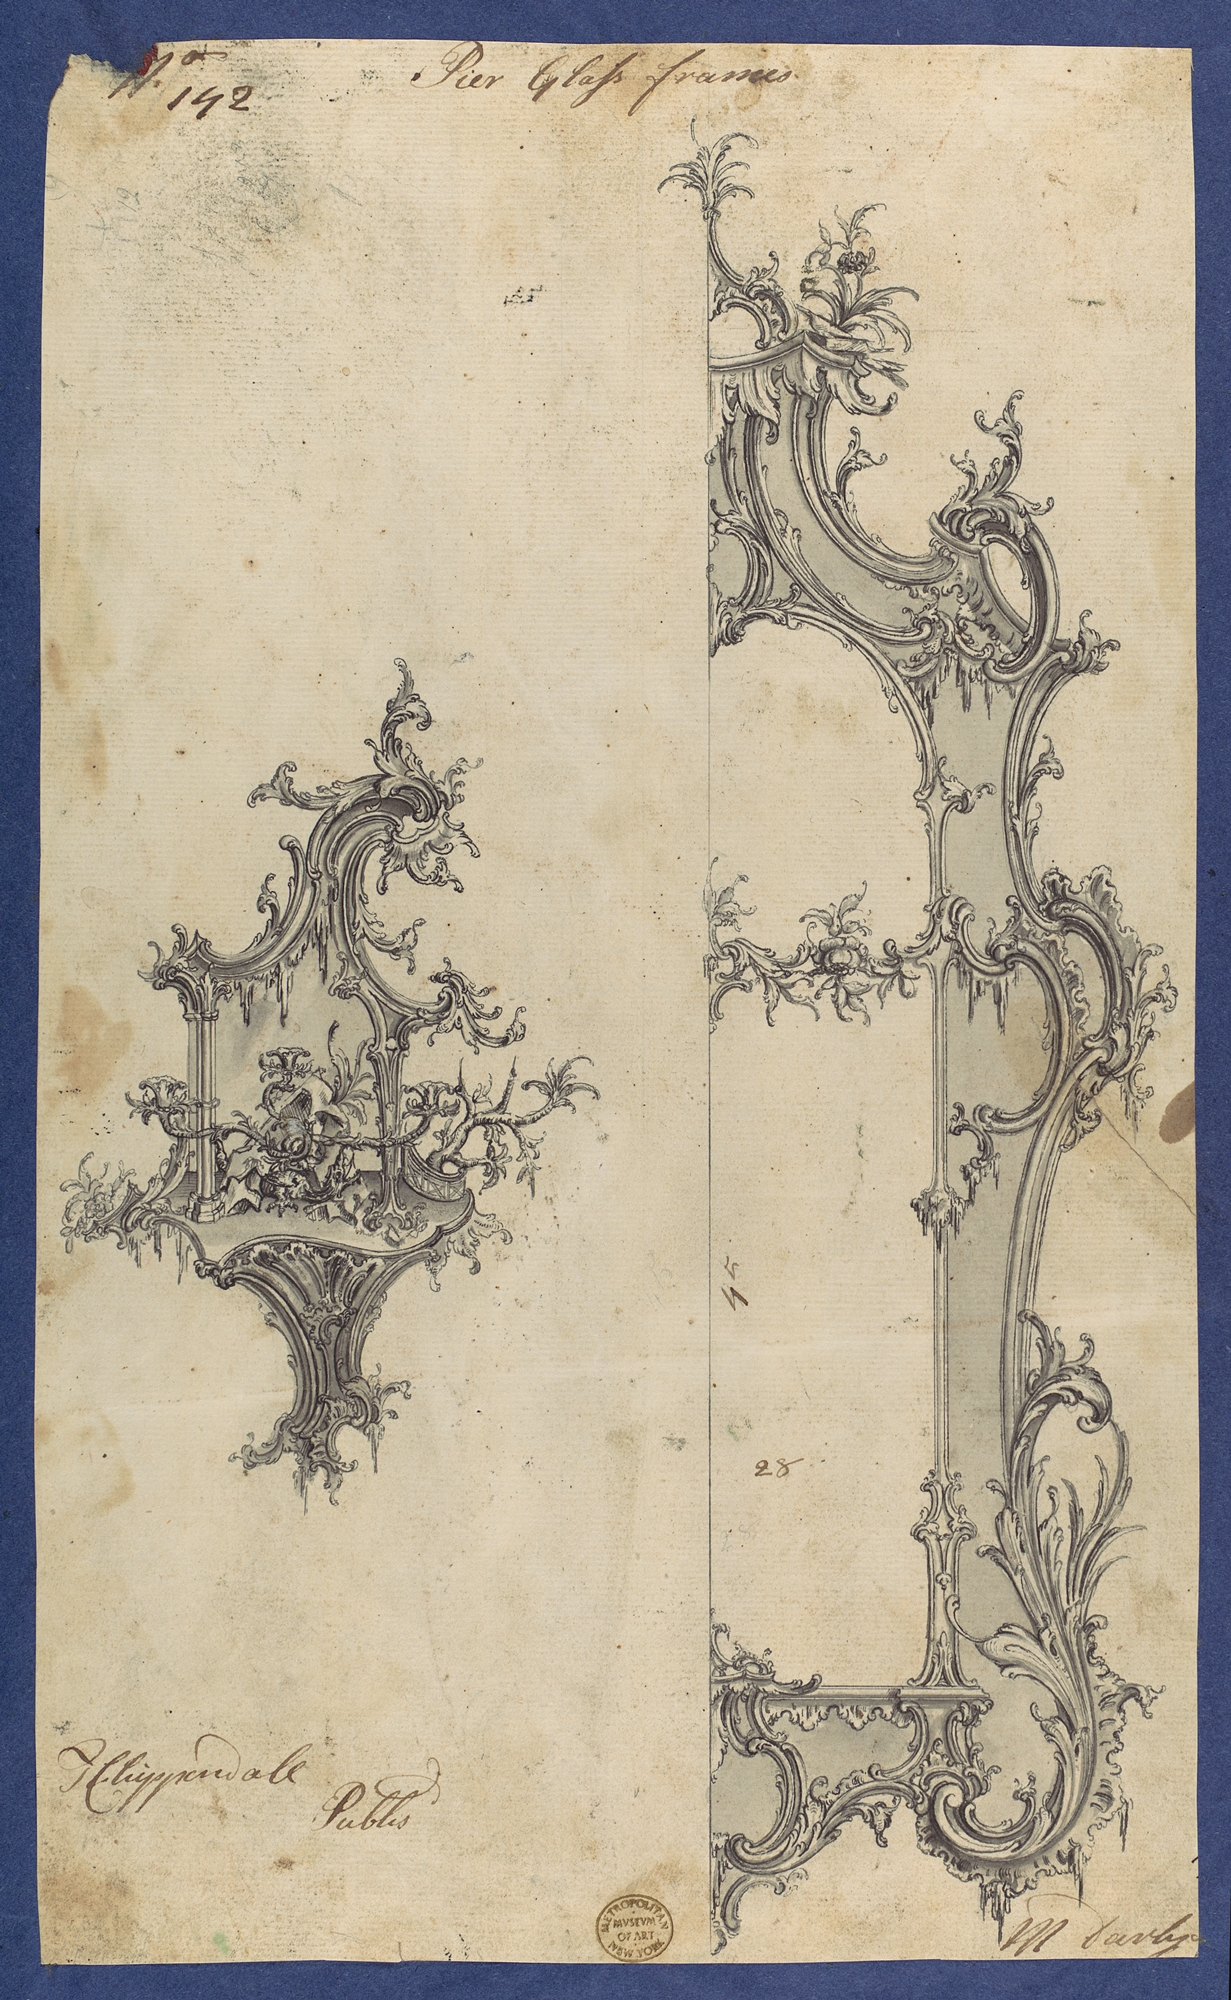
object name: drawing ornament architecture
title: Pier Glass Frames, in Chippendale Drawings, Vol. I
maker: thomas chippendale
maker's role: artist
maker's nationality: british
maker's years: 1718-1779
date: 1754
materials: ink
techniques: wash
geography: london